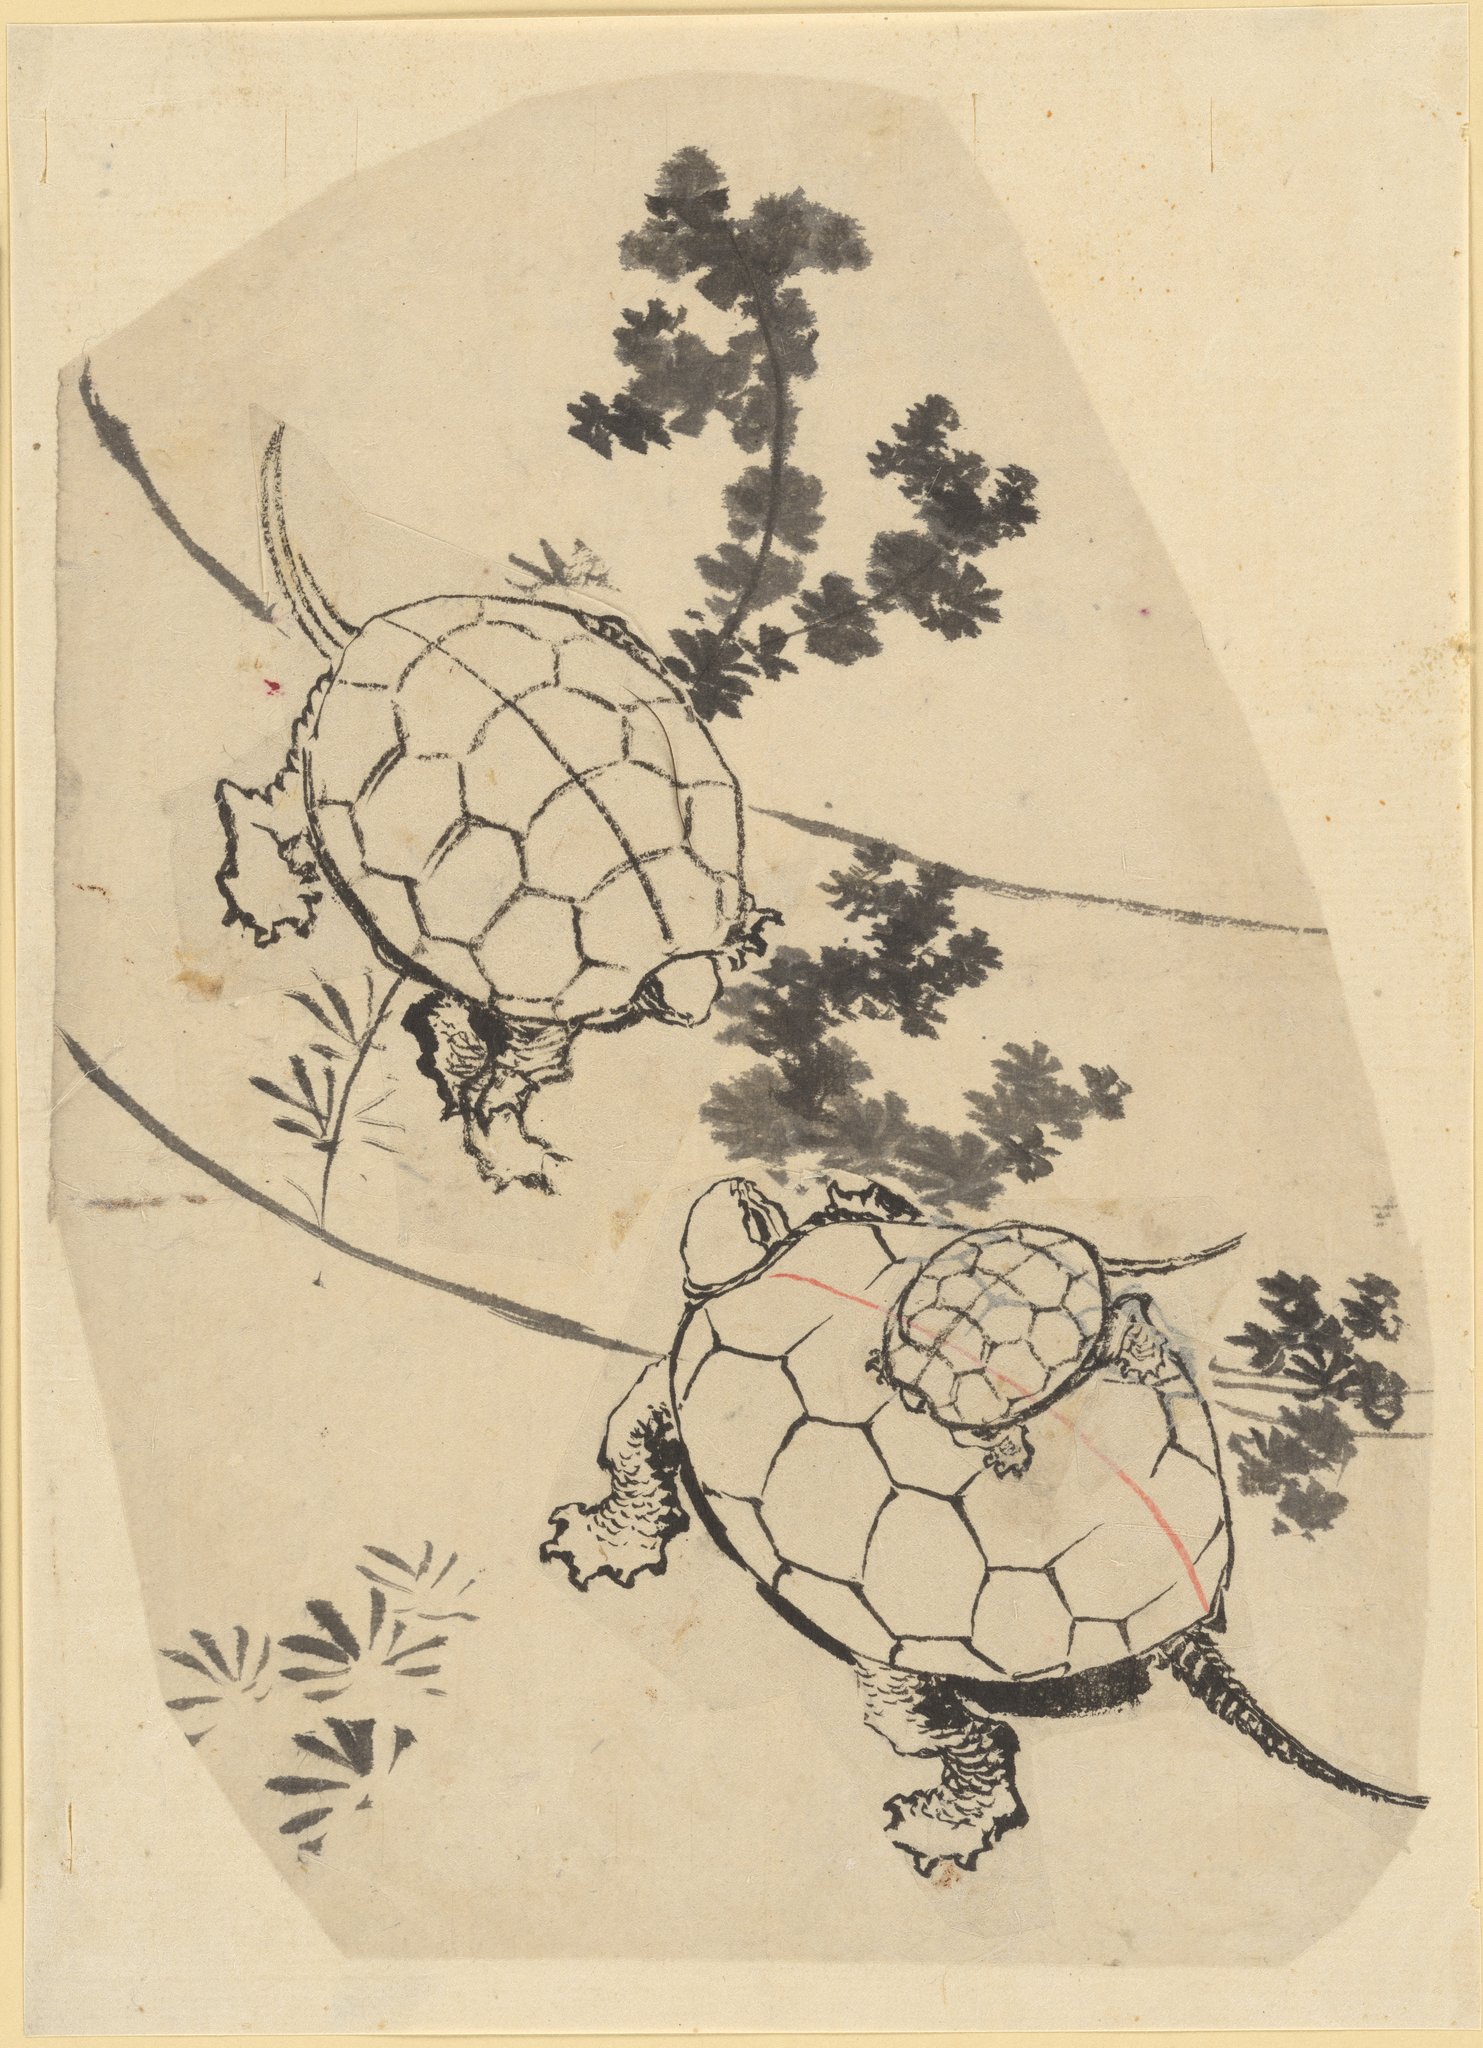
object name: drawing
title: Turtles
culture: japanese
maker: katsushika hokusai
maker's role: artist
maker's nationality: japanese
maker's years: 1760-1849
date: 1701-1900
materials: ink, paper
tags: turtles